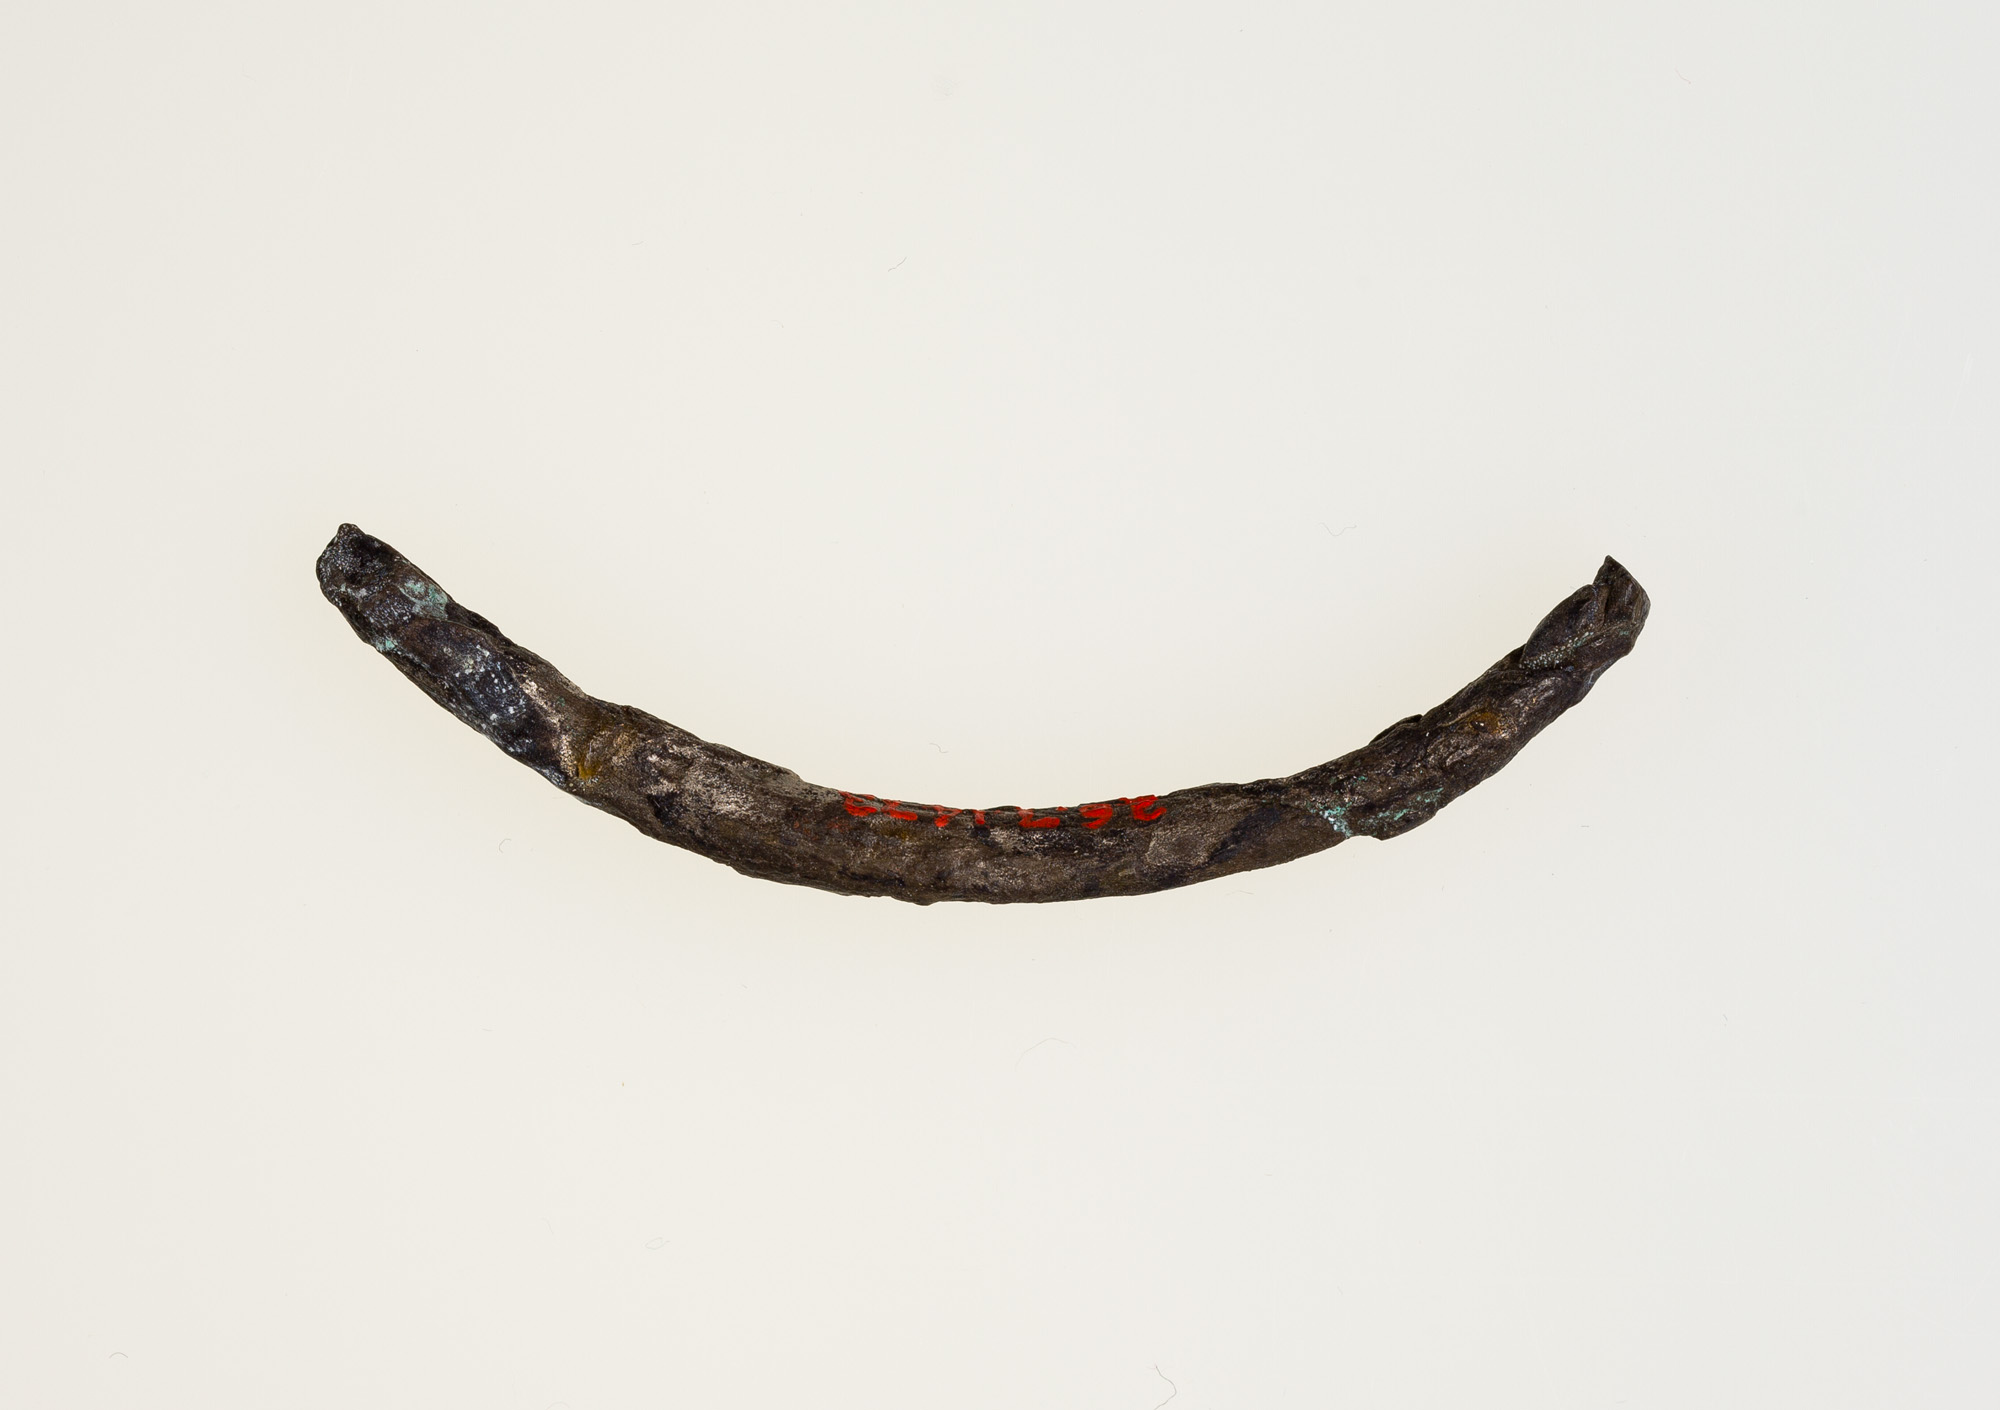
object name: bracelet, bangle, fragment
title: Part of a bangle (?)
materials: silver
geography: egypt